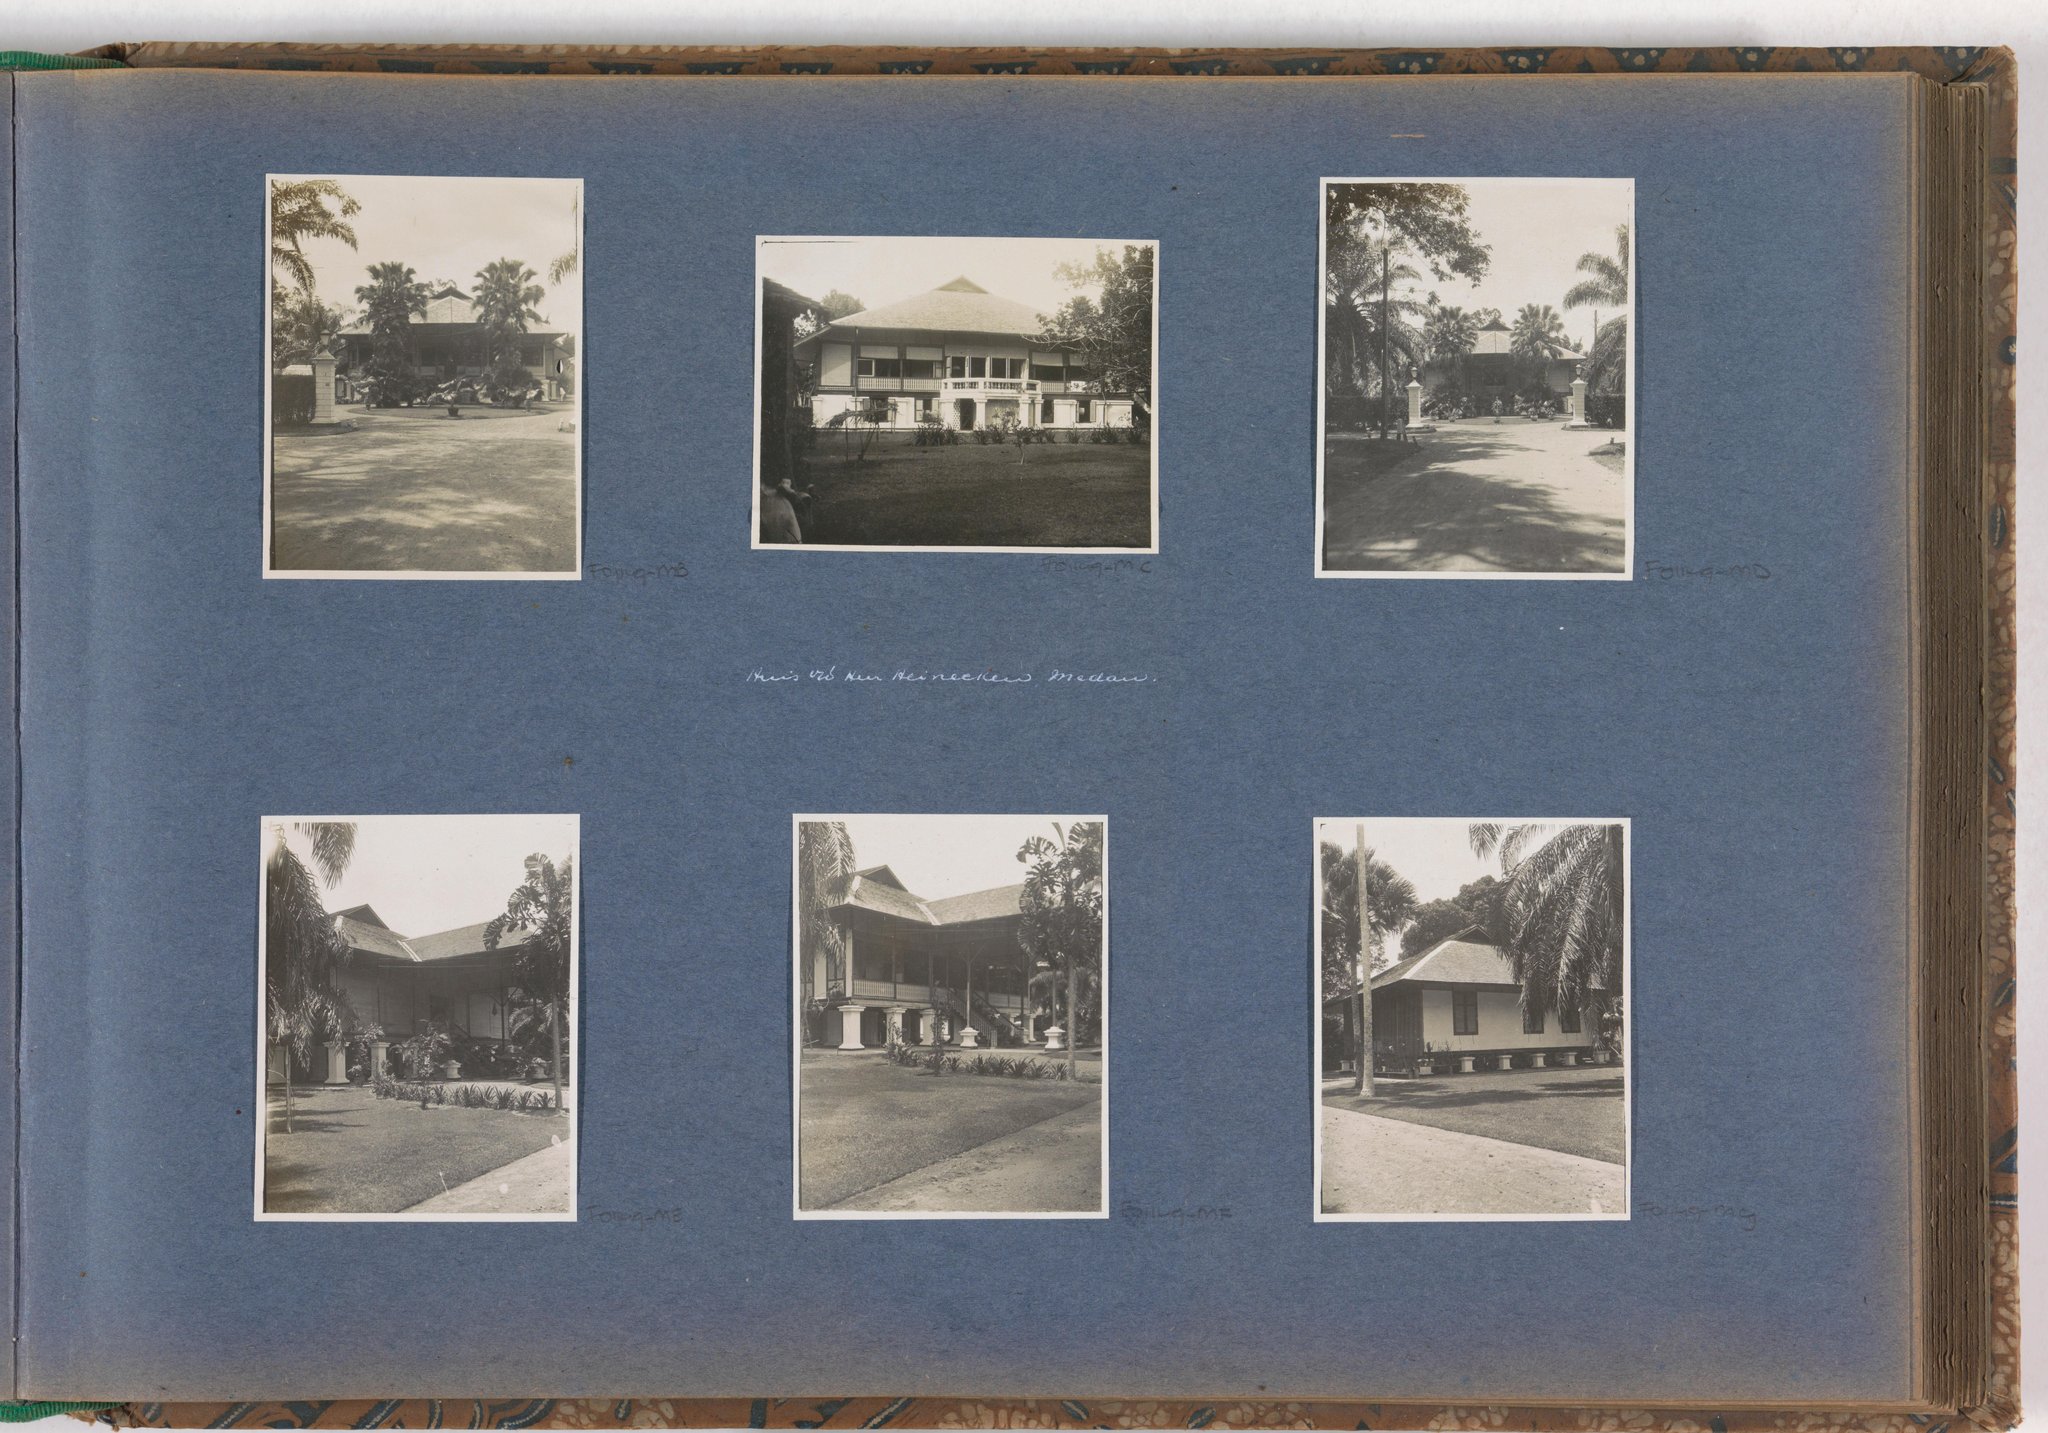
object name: album leaf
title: Huis van de heer Heinecken in Medan gezien door de poort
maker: Anonymous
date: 1900-1920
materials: paper, photographic support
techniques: gelatin silver print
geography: medan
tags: rural housing, e.g. country-house, villa, cottage, gate, entrance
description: Onderdeel van reisalbum met foto's van bedrijvigheid en bezienswaardigheden op Sumatra en Java en van de reis naar en van Nederlands-Indië.